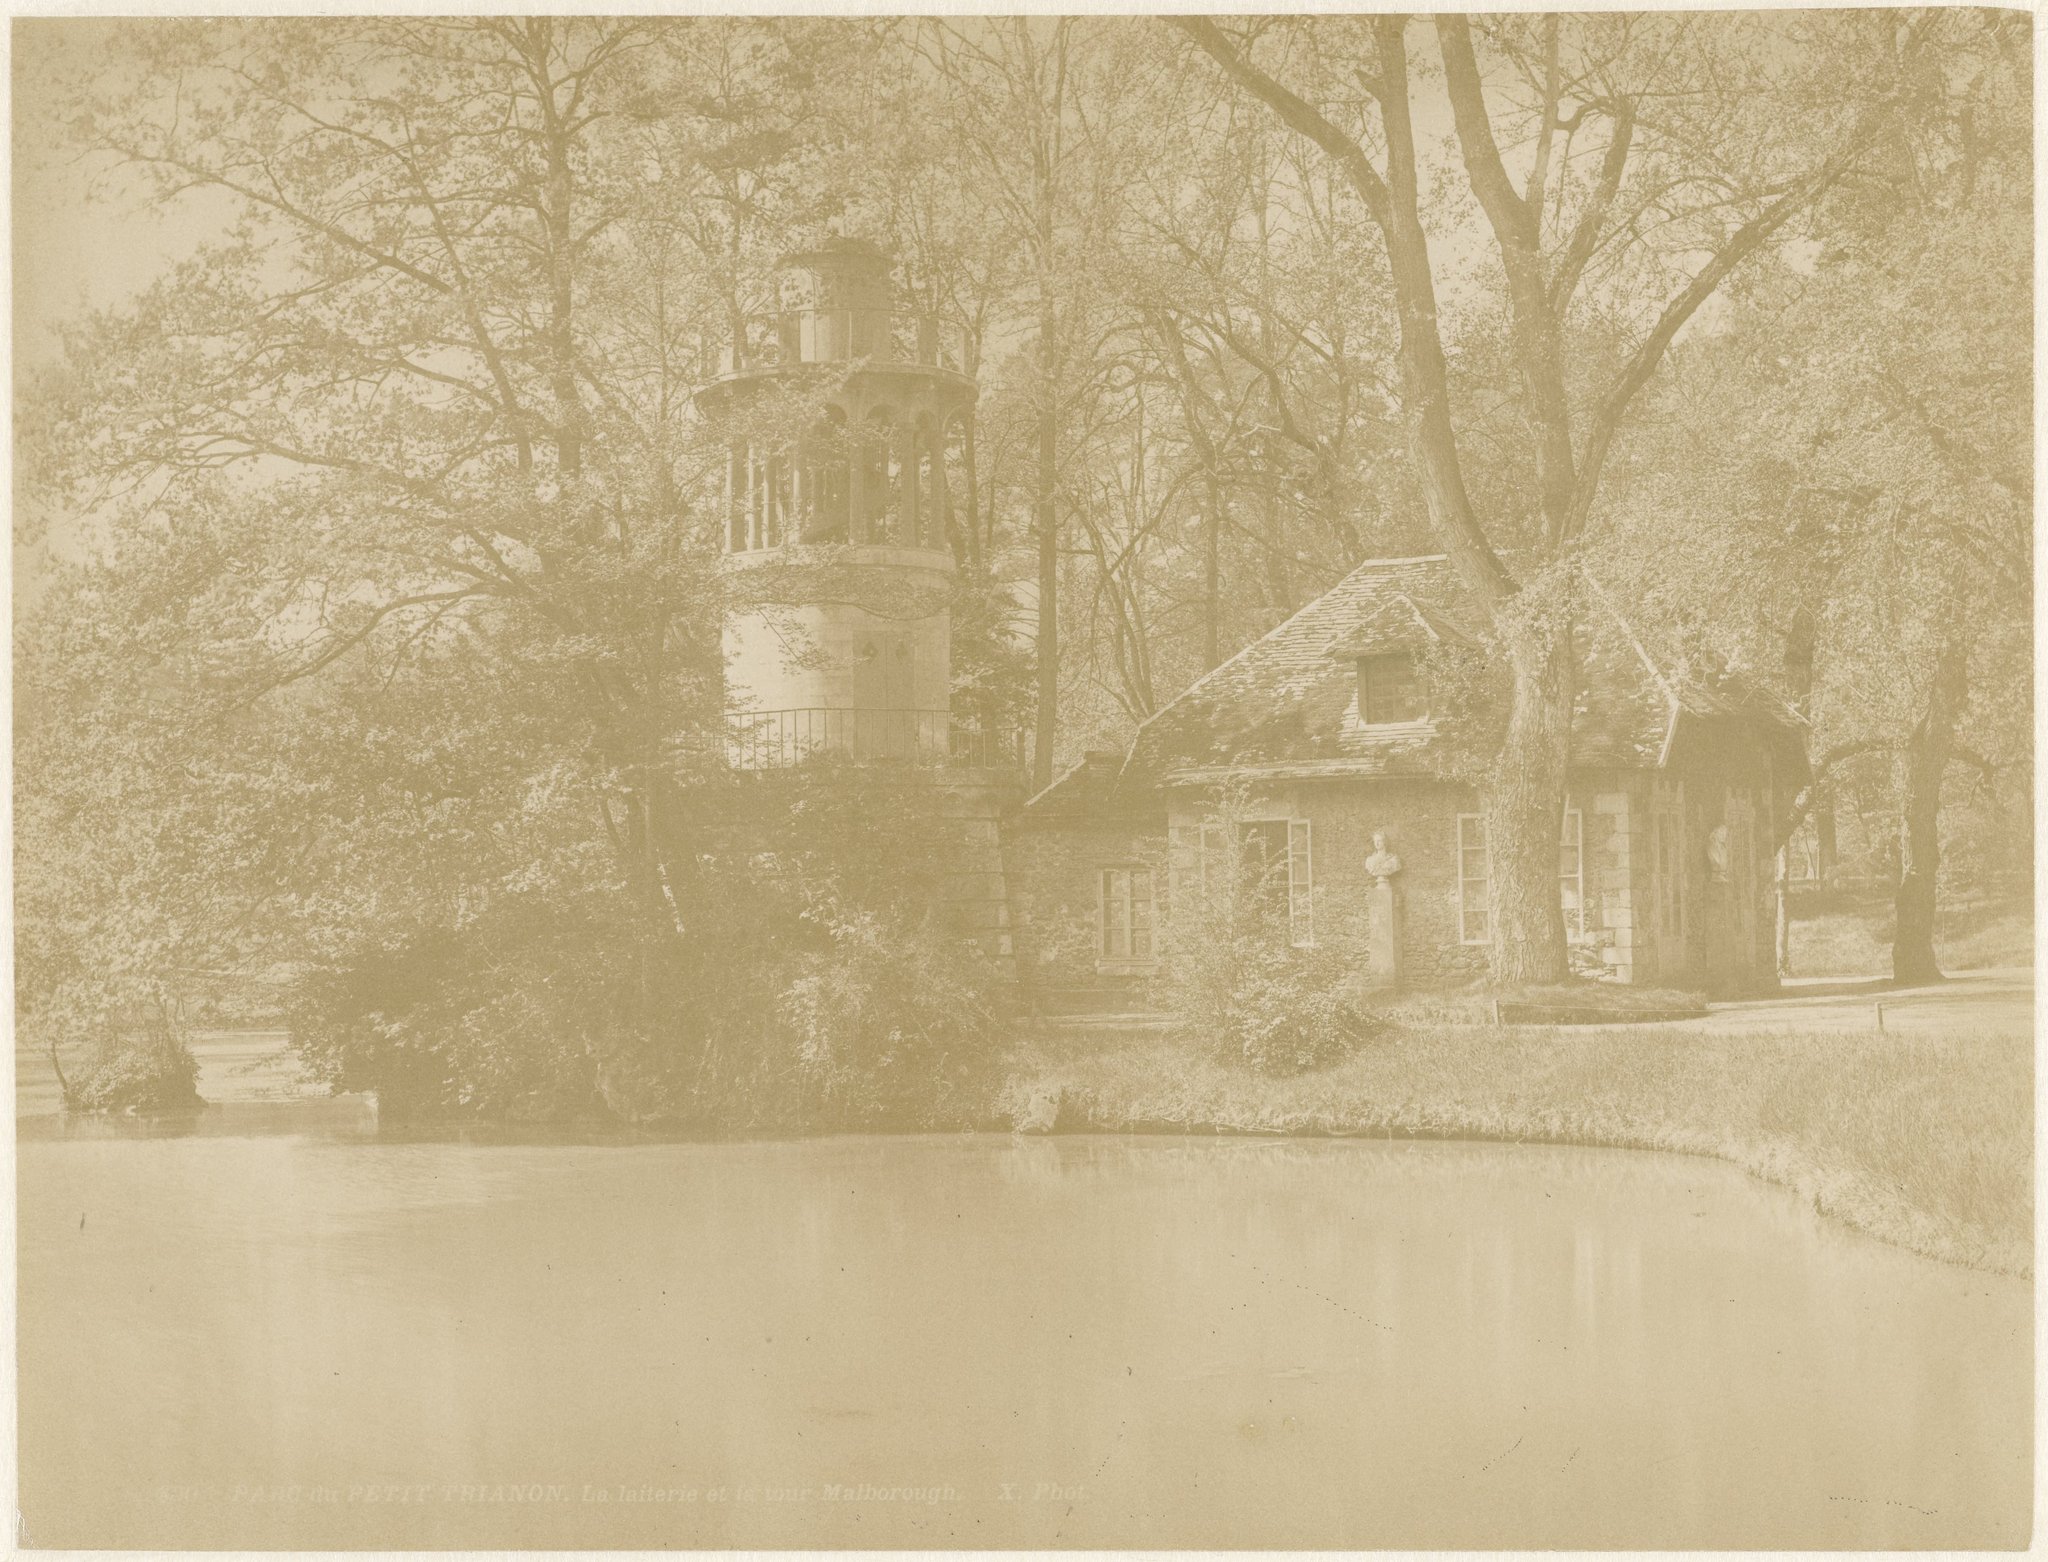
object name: photograph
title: Parc du Petit Trianon, la laiterie et la tour Marlborough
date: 1887-1900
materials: paper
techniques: albumen print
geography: versailles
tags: tower (of house or building), farm (building)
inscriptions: number: ‘300 [?]’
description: Tussen 1887 en ca. 1900 werkten Neurdein frères onder andere onder de naam 'X phot.'.